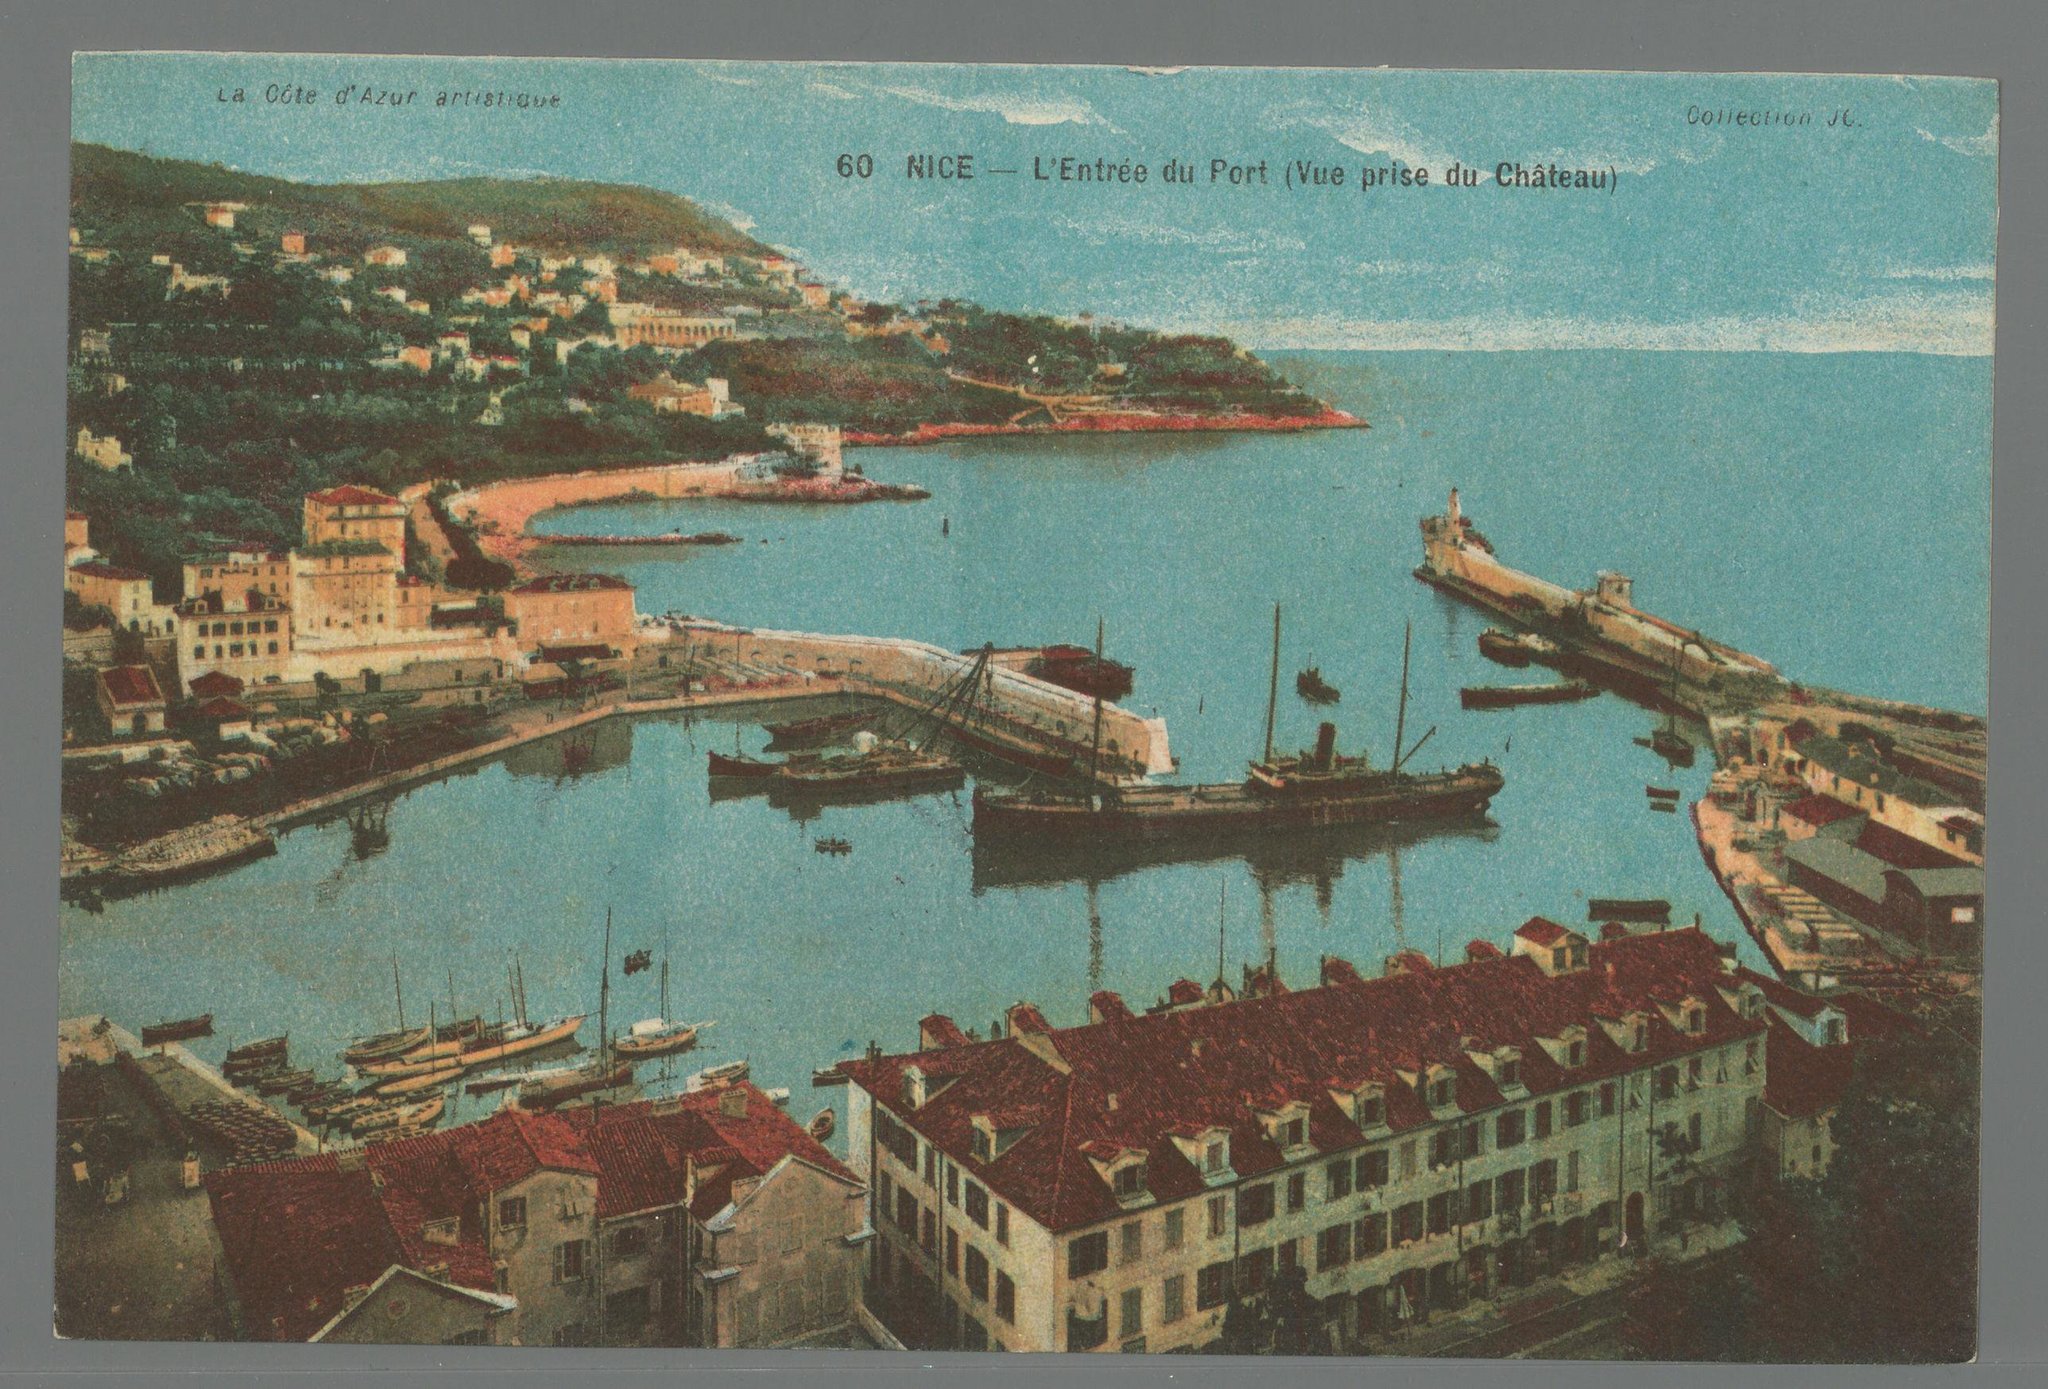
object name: photomechanical print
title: La Côte d'Azur artistique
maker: Anonymous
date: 1904-1906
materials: cardboard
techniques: photograph, lithograph, writing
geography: nice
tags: harbour, urban housing, landscapes with waters, waterscapes, seascapes (in the temperate zone)